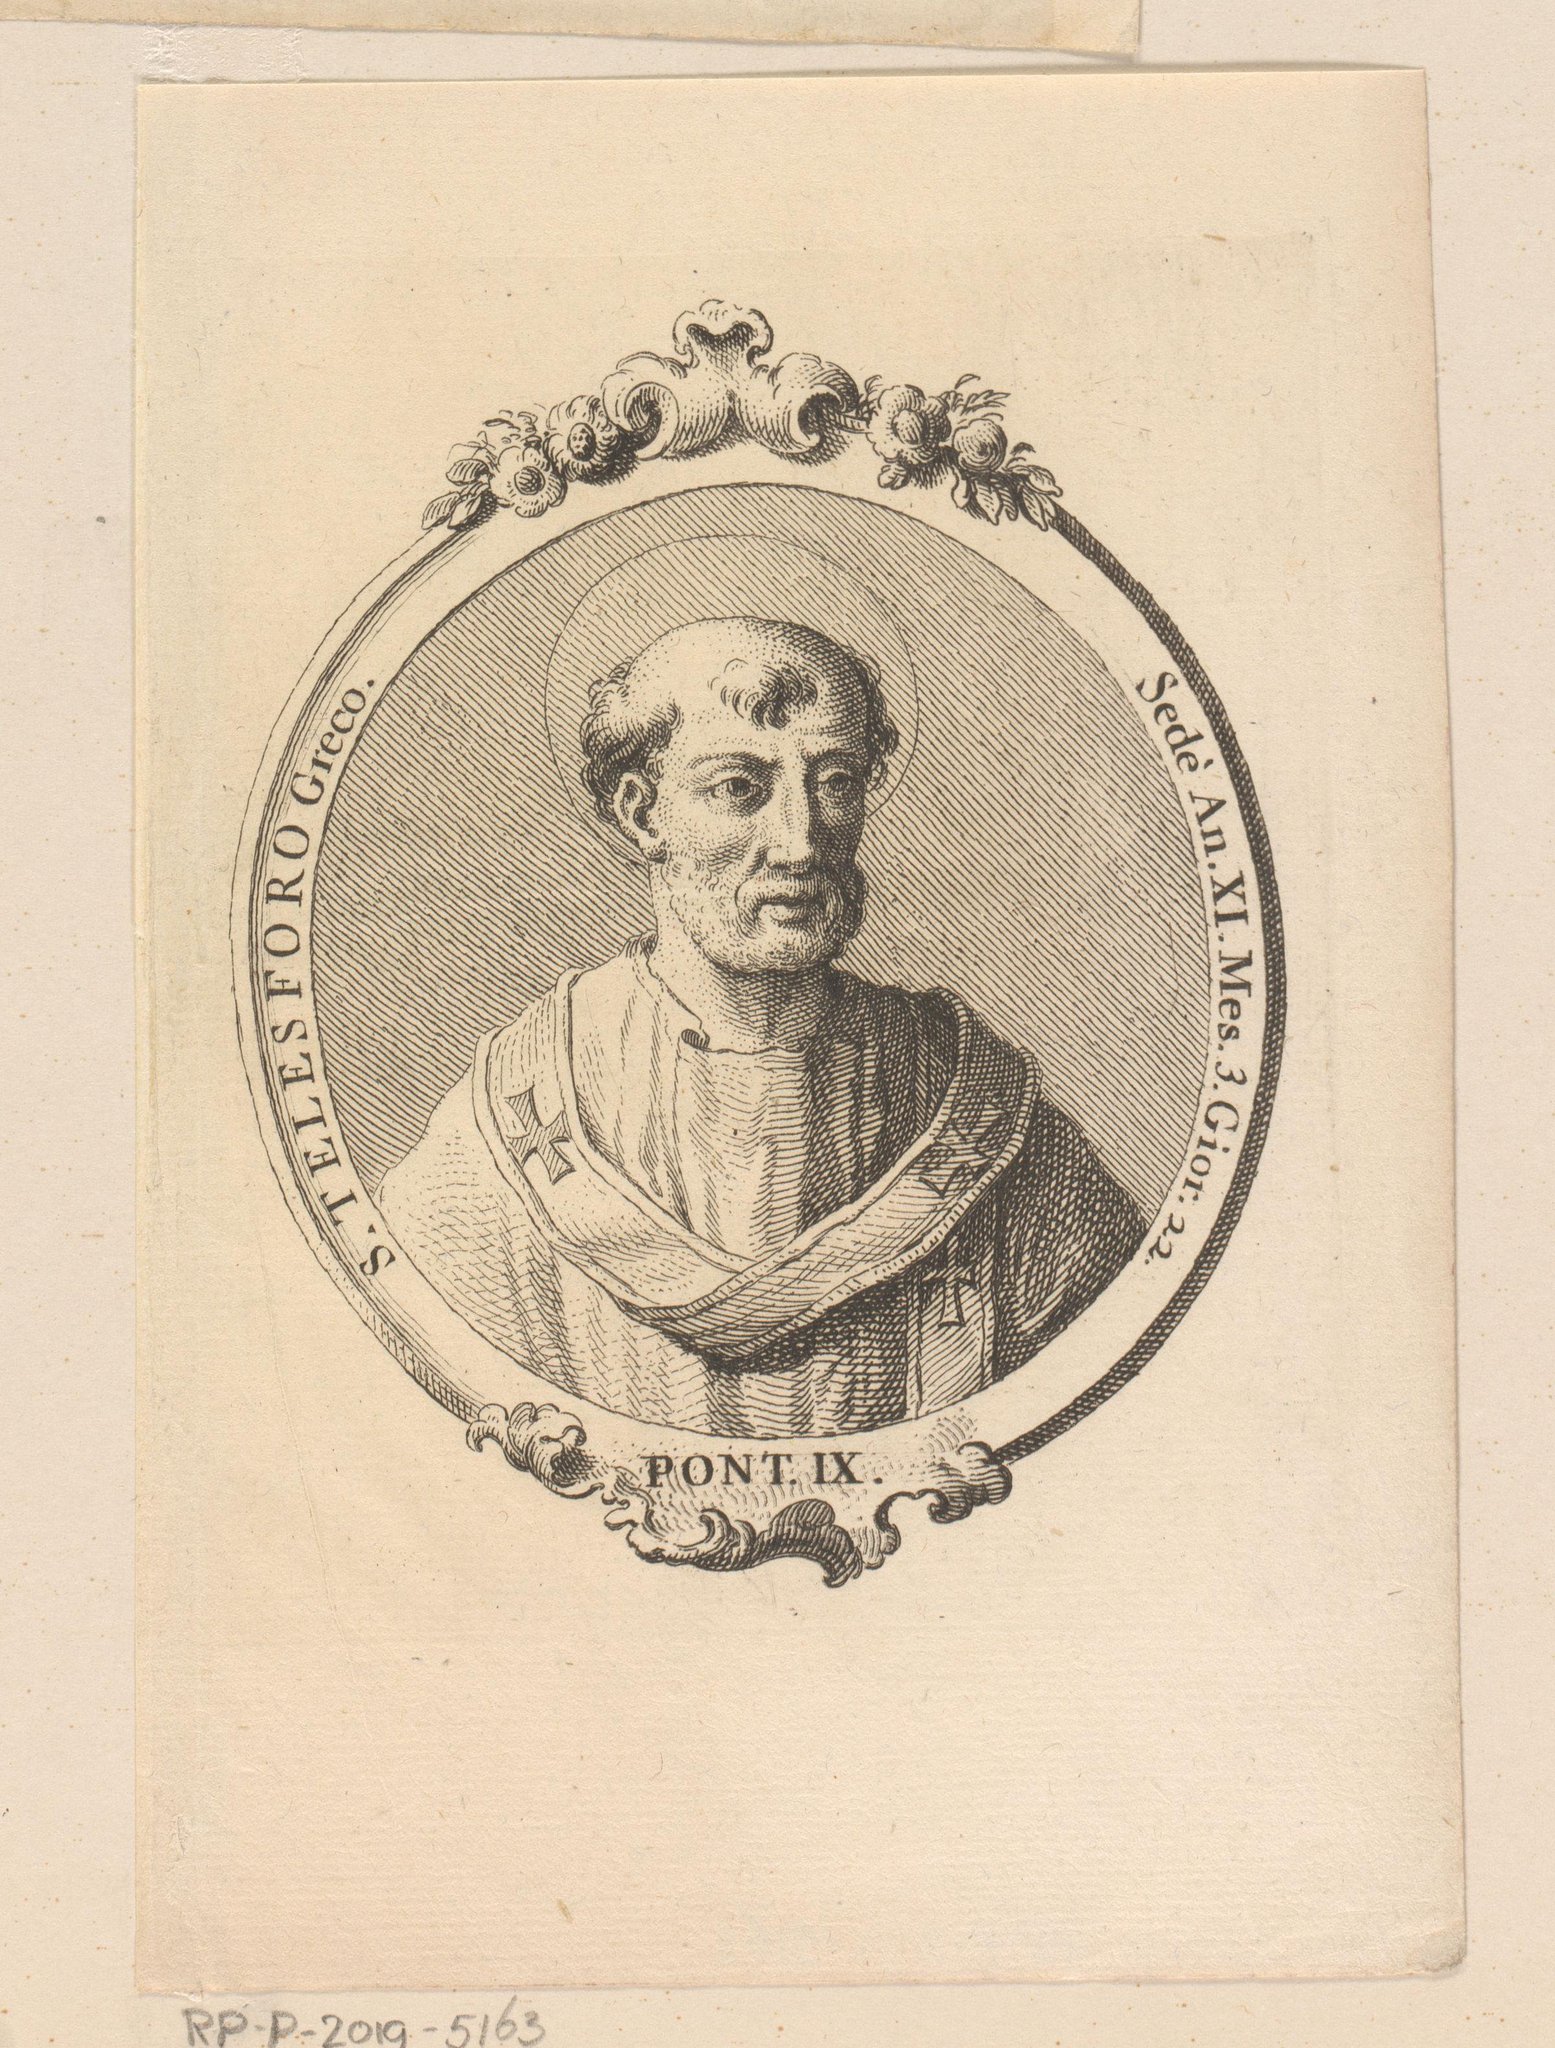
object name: print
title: Portret van paus Telesforus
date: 1775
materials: paper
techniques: engraving, etching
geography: venice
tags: historical persons, pope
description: Prent uit: Effigies Romanorum pontificum a S. Petro ad Pium VI. feliciter regnantem (...). 2 dln. Venetië en Bassano del Grappa: Giuseppe Remondini, 1775.